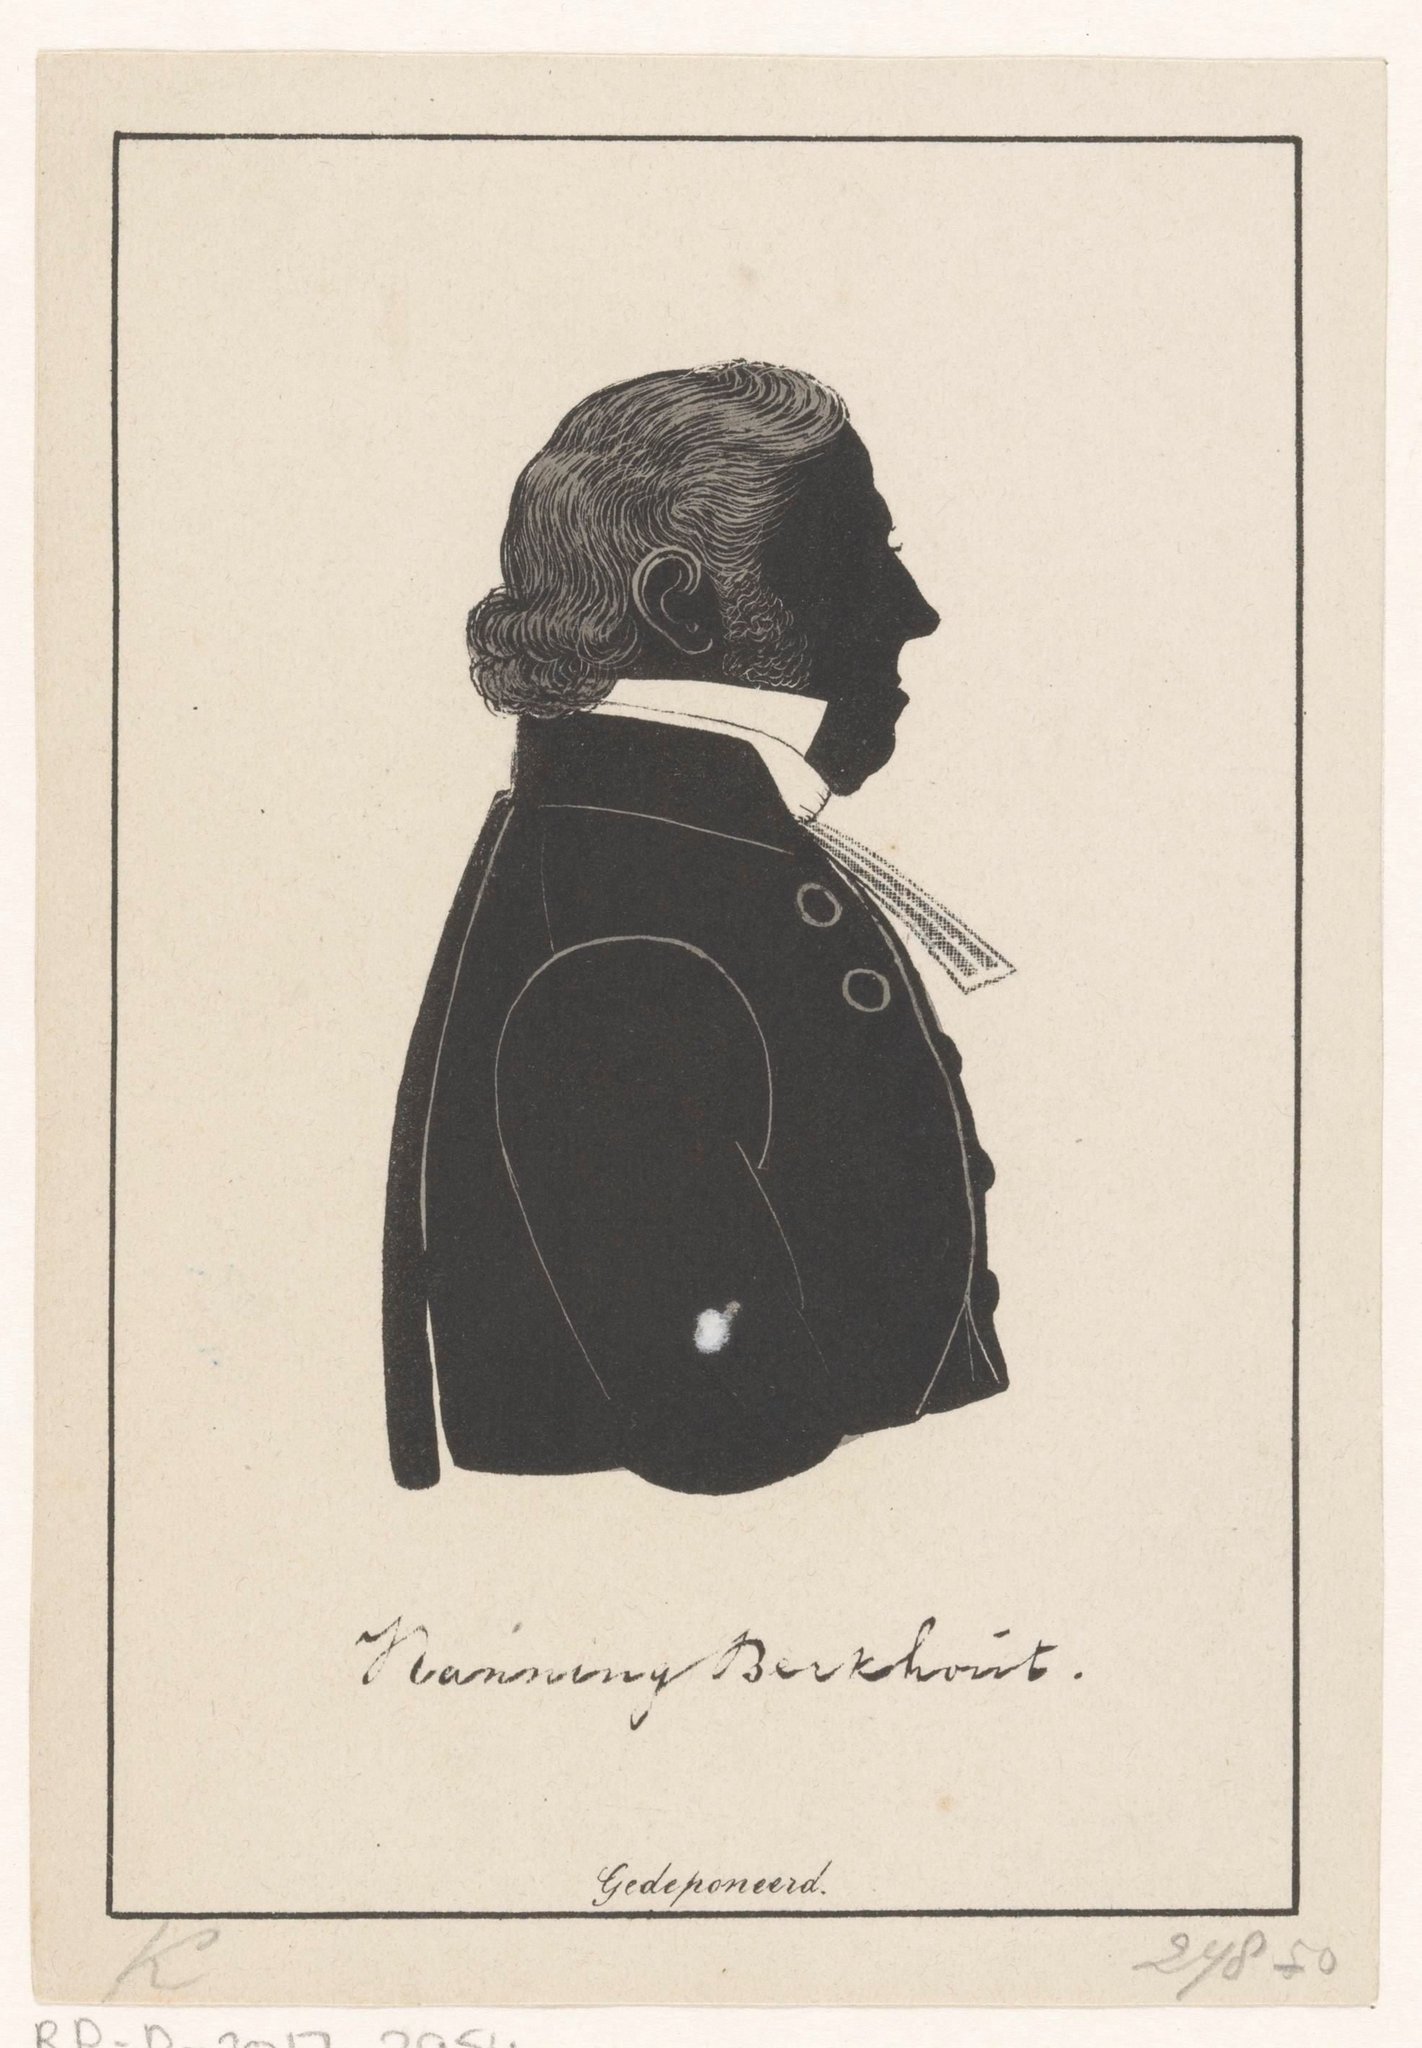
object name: print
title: Silhouetportret van Nanning Berkhout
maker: pieter barbiers (iv)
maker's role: painter, print maker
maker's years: 1798-1848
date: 1809-1848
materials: paper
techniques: hand coloring, lithograph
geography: netherlands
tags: maarssen, leiden, historical persons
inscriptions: : ‘Gedeponeerd.’, collector's mark: Lugt 2228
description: Onder het portret de signatuur van de geportretteerde.